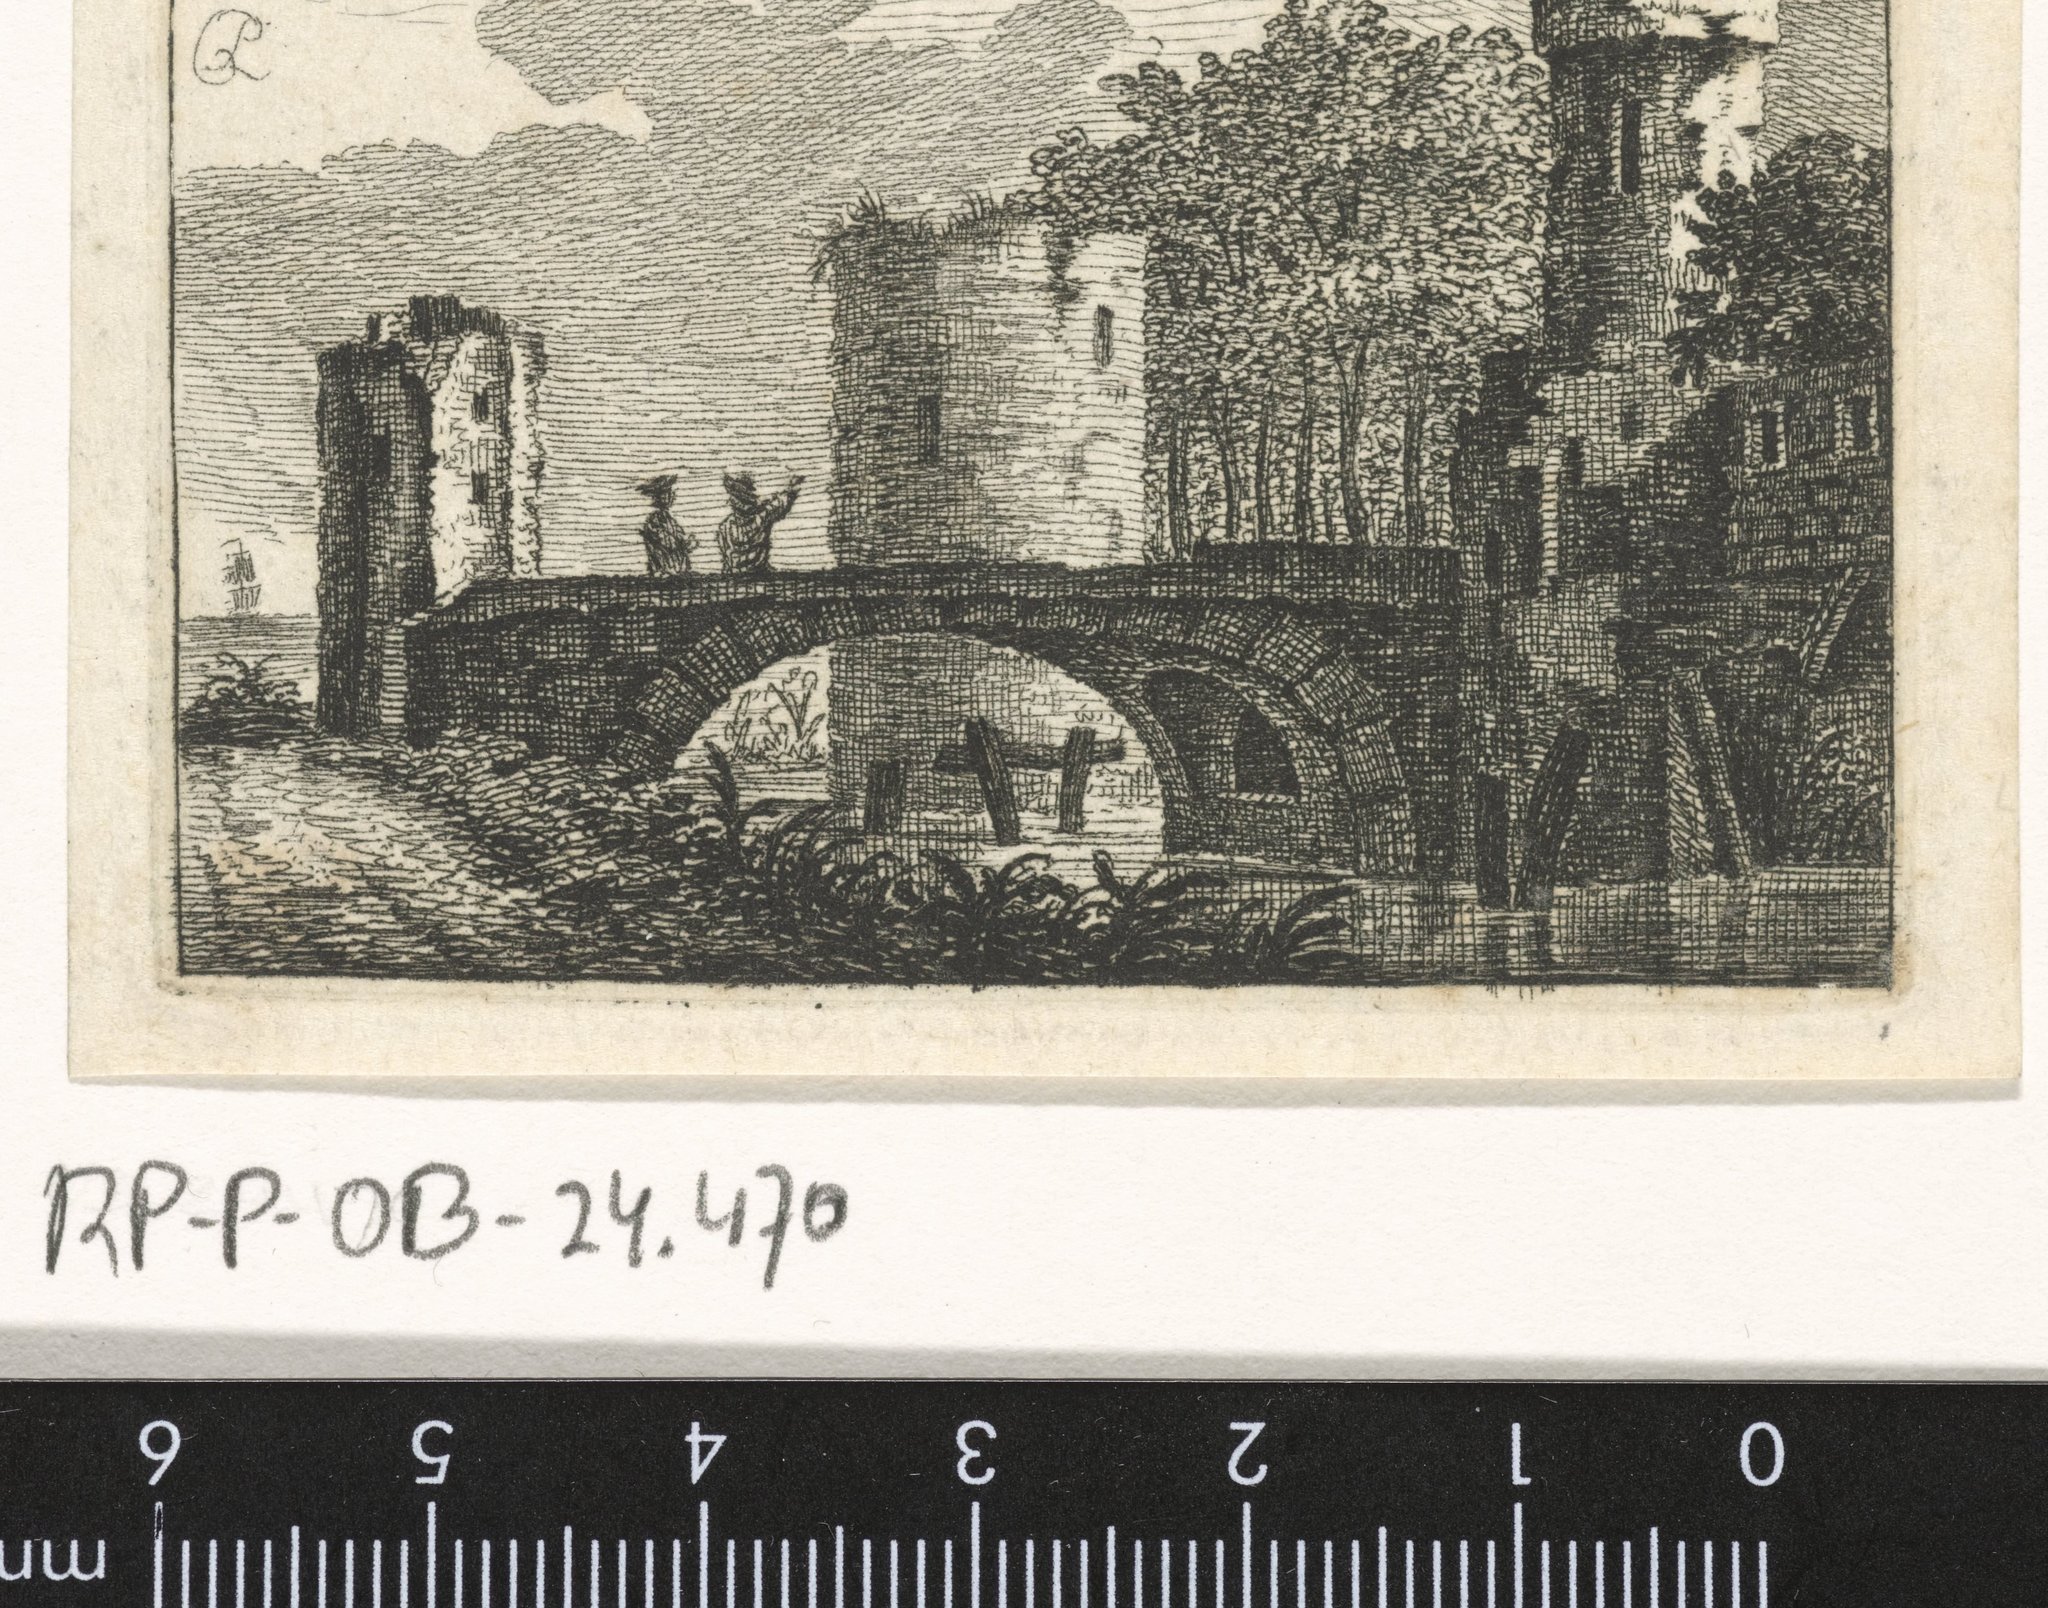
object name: print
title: Landschapjes, Rúwientjes enz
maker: caspar jacobsz. philips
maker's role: draughtsman, print maker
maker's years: 1732-1789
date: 1766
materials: paper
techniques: etching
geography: amsterdam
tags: landscape with bridge, viaduct or aqueduct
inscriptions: collector's mark: Lugt 240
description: Landschap met de ruïne van een kasteel. In het midden twee figuren in gesprek op een boogbrug.